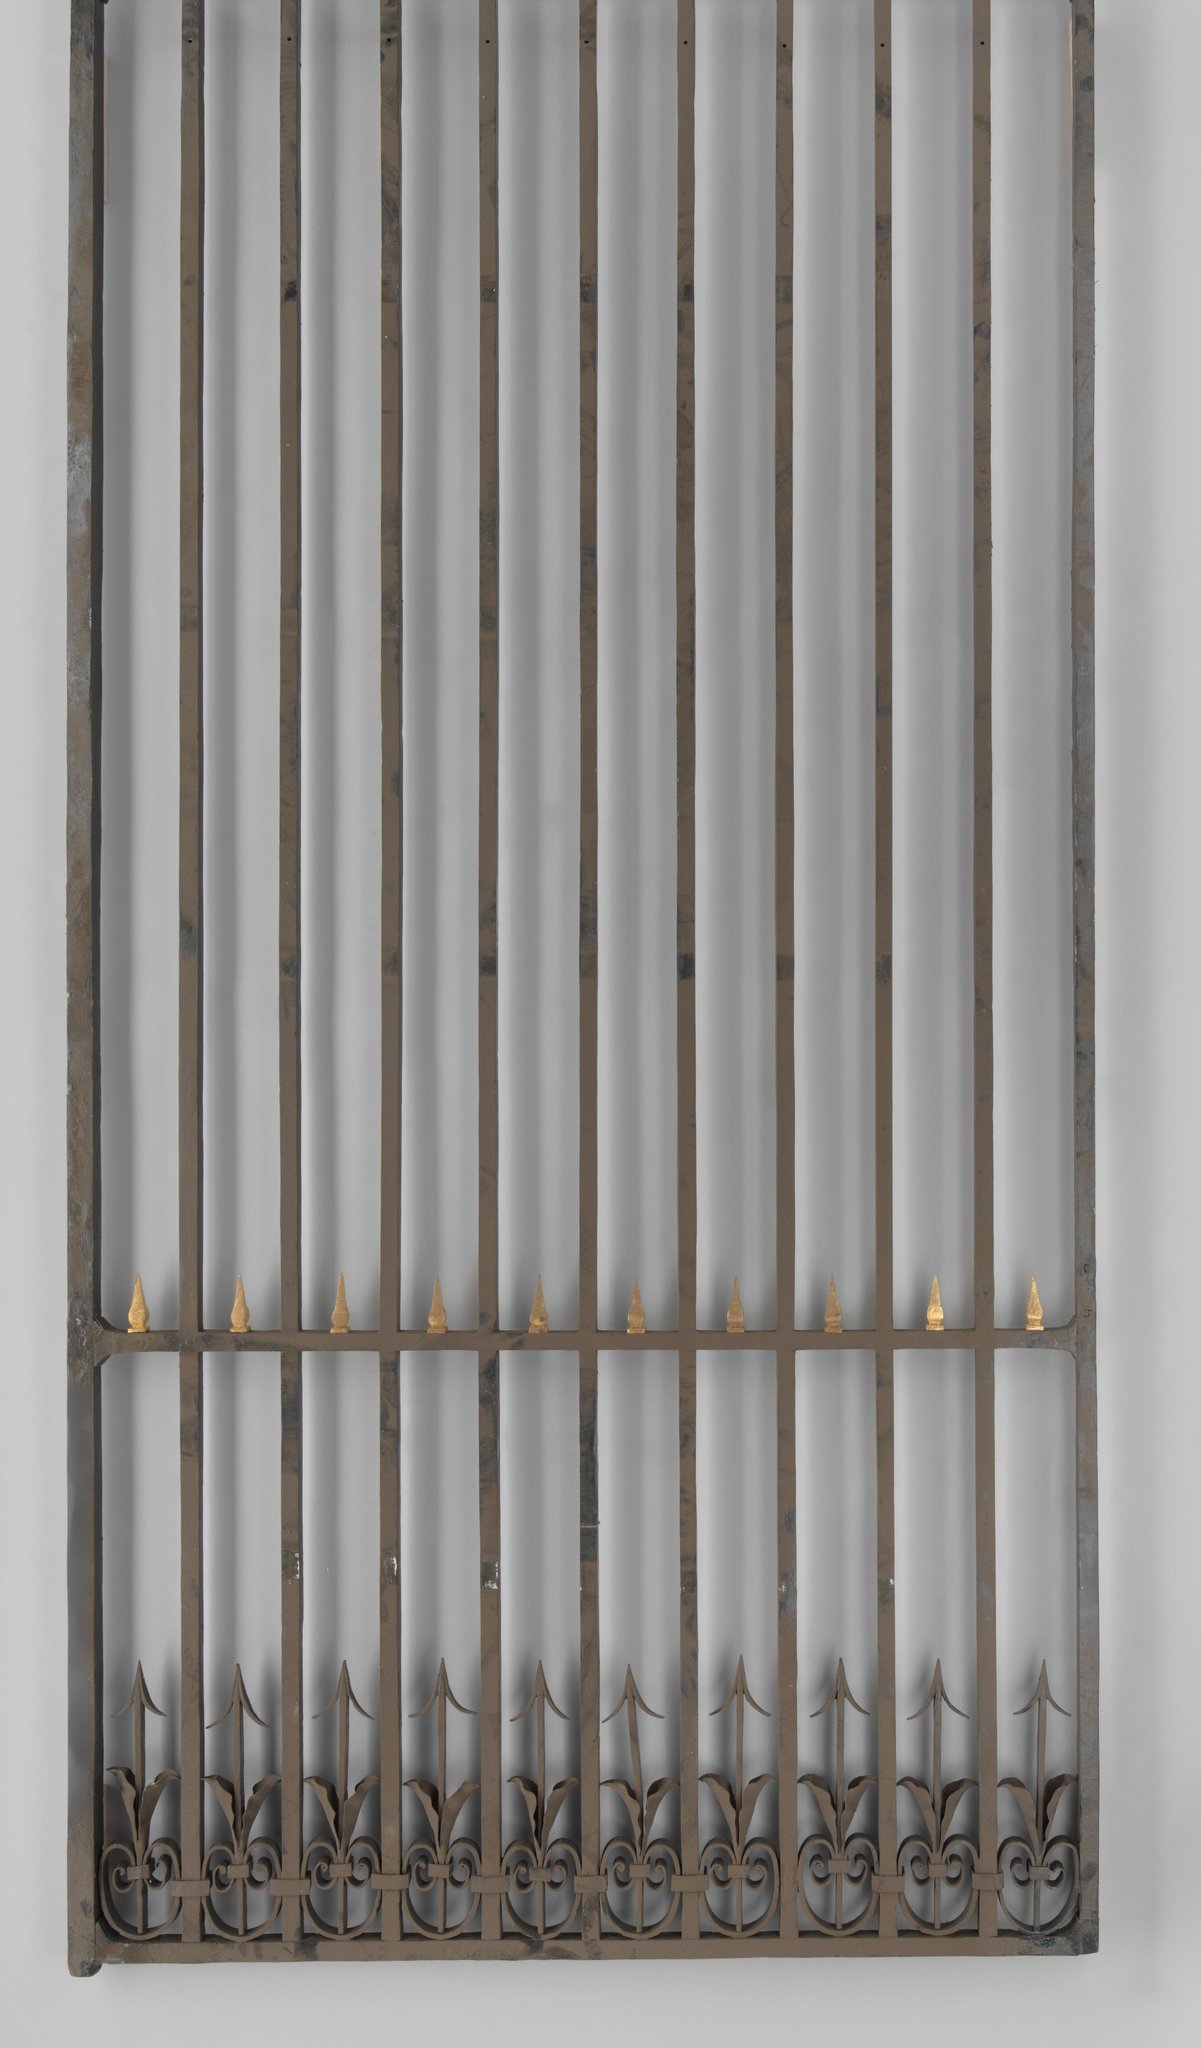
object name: hek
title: Poort, hekdeel van het inrijhek Huize de Voorst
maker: daniël marot (i)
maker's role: draughtsman, print maker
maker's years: 1661-1752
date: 1675-1700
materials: iron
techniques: forging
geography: warnsveld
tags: huis de voorst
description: Smeedijzeren poort van het inrijhek van Huize de Voorst.